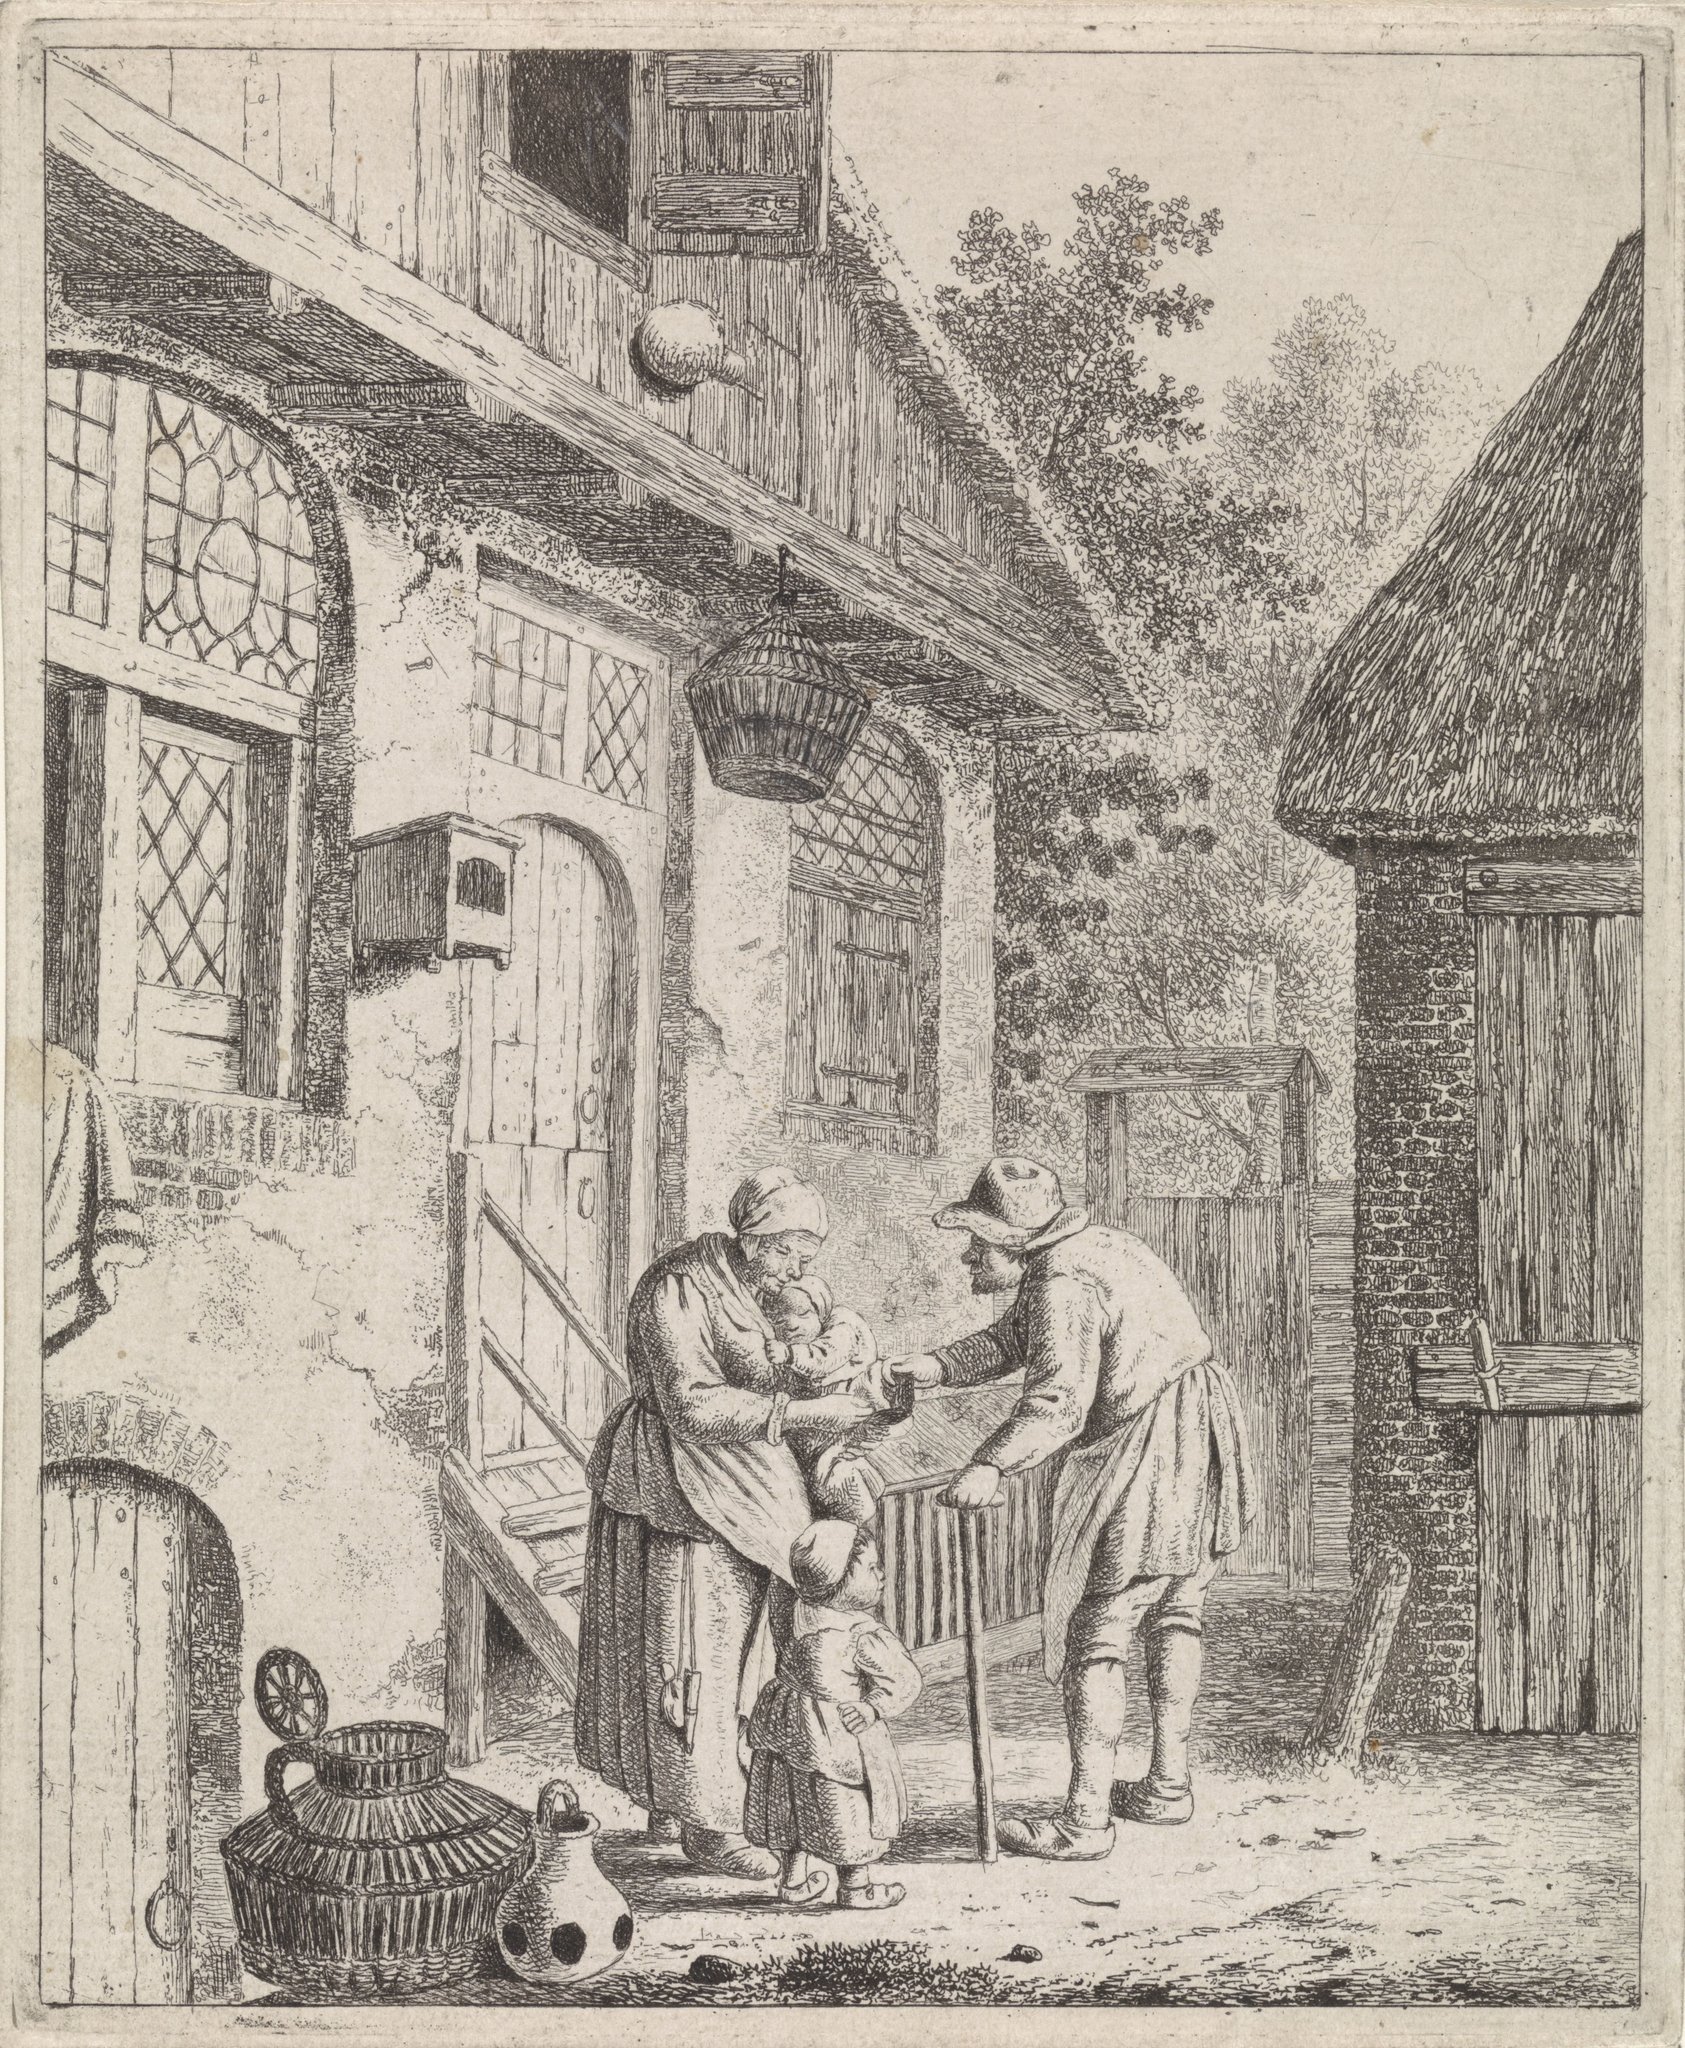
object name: print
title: Binnenplaats met boeren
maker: johannes christiaan janson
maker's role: draughtsman, painter, print maker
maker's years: 1763-1823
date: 1778-1823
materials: paper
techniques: etching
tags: mother and baby or young child, courtyard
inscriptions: collector's mark: Lugt 2228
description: Binnenplaats met een vrouw en twee kinderen voor een huis. De vrouw houdt het jongste kind op haar arm. Voor hen een man, op een stok leunend. Links op de voorgrond een mand en kan. Mét bomen op de achtergrond. Meer bewerkt dan vorige staat.